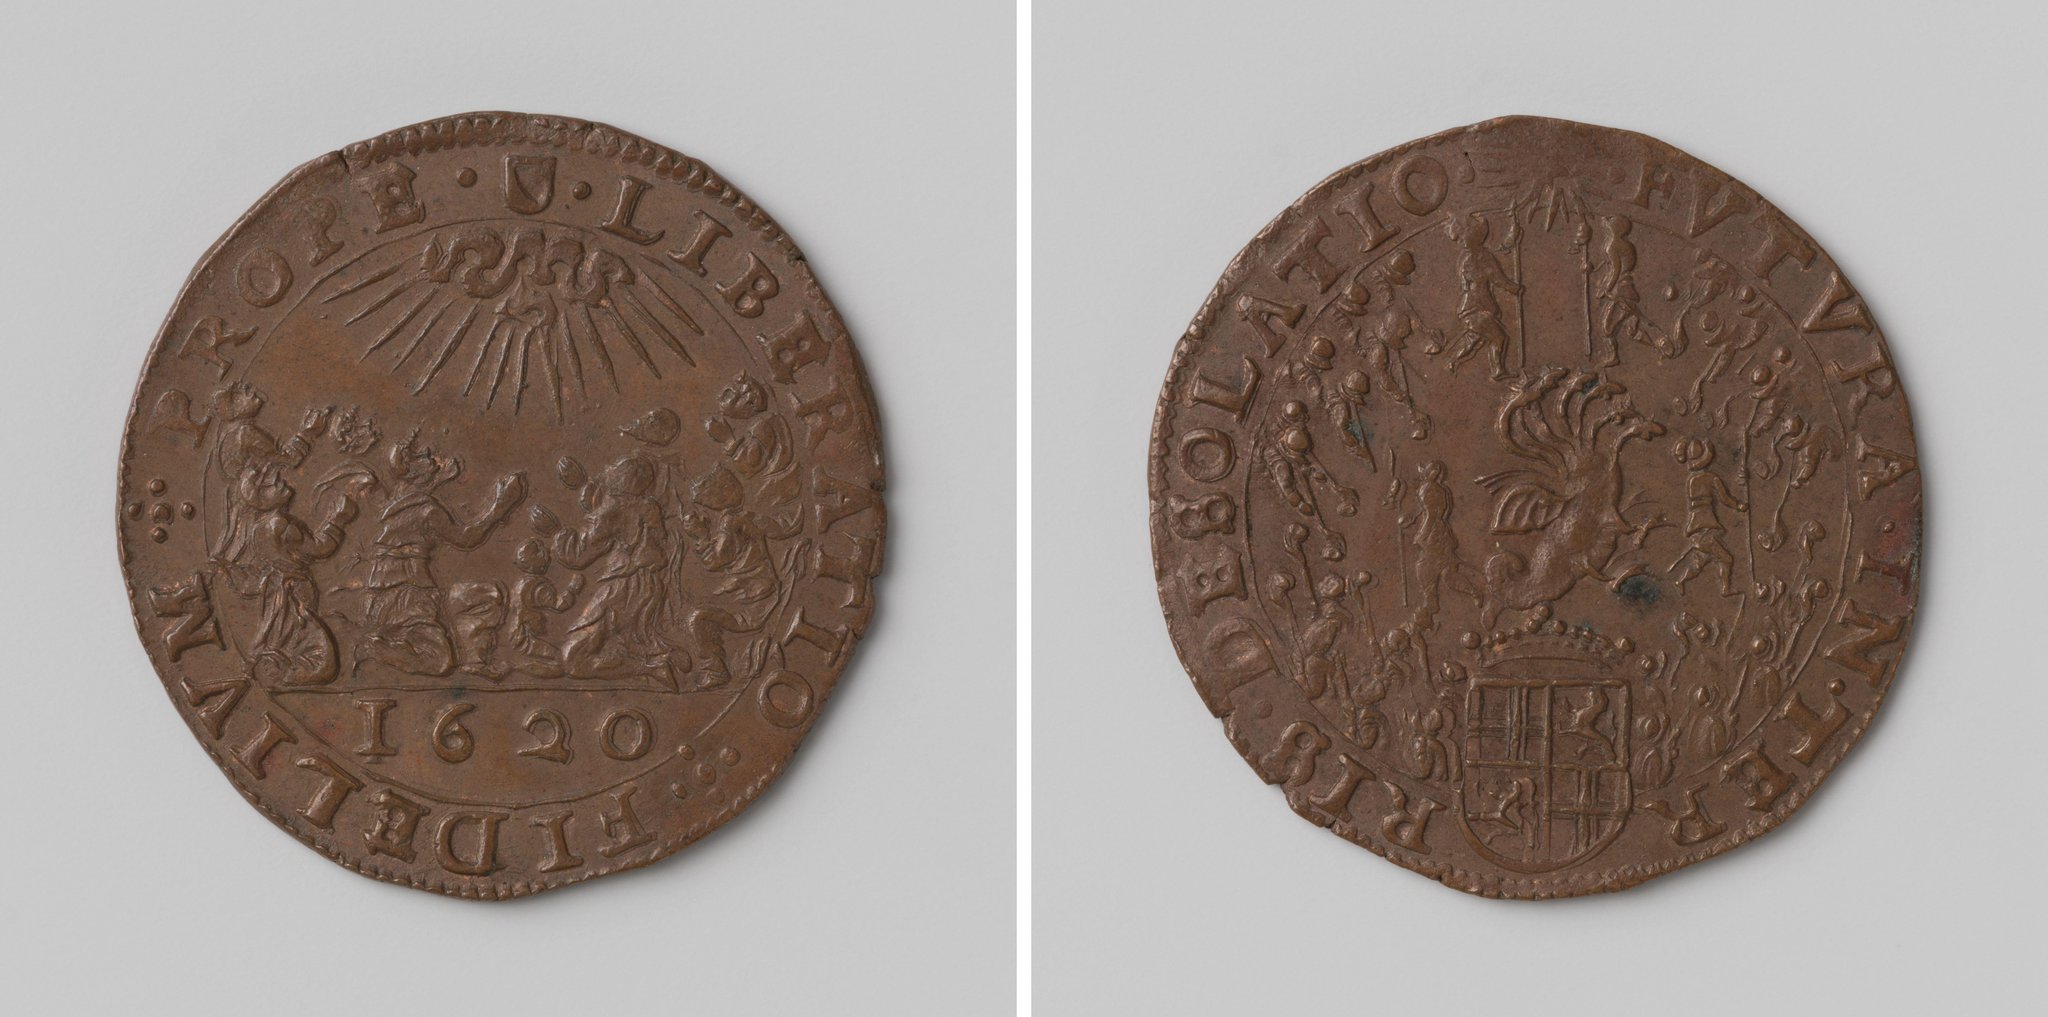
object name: jeton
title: Steun van de Republiek der Zeven Verenigde Nederlanden aan Frederik V, koning van Bohemen in de oorlog tegen de keizer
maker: Anonymous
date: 1620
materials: copper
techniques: striking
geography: utrecht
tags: staten-generaal, staten van utrecht, eemland, dertigjarige oorlog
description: Koperen penning. Voorzijde: knielende mensen met gevouwen handen bidden met blik omhoog gericht naar stralend hemellicht binnen omschrift; afsnede: jaartal. Keerzijde: zevenkoppig beest omgeven door soldaten boven gekroond wapenschild binnen omschrift